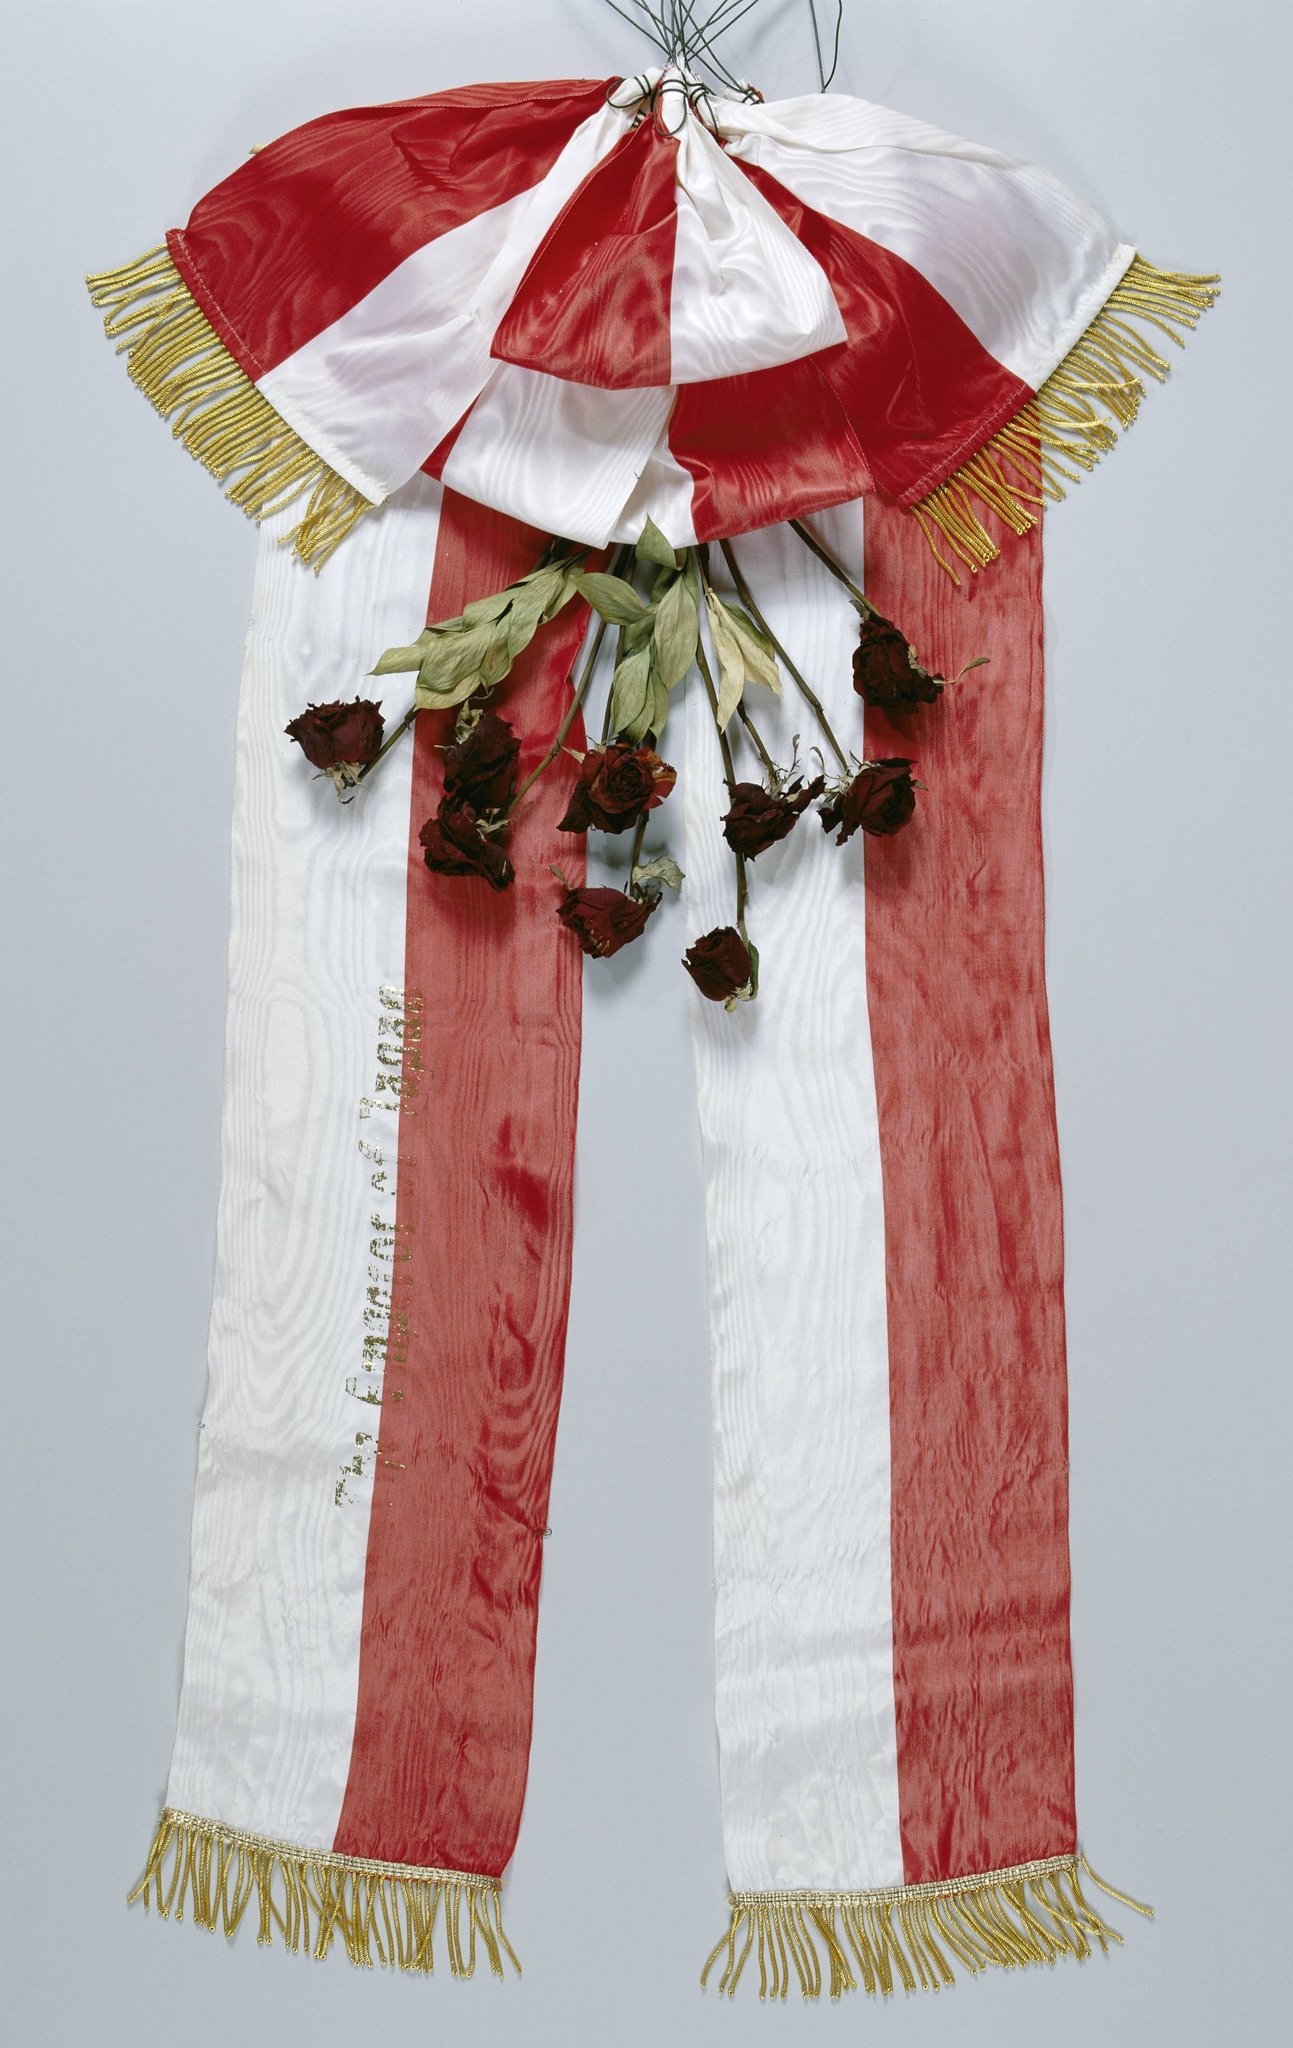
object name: roos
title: Rozen behorende bij de krans voor slachtoffers van het Japanse optreden tijdens de Tweede Wereldoorlog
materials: textile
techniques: treatment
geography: the hague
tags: japan, amsterdam, indonesia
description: Staatsbezoek van het Japanse keizerlijke paar in Nederland mei 2000. Het bezoek stond in het teken van de viering van de 400 jaar oude betrekkingen tussen Nederland en Japan. Zij legden de krans op 23 mei bij het Nationaal Monument op de Dam. Van de krans is de lint bewaard (NG-2000-6).